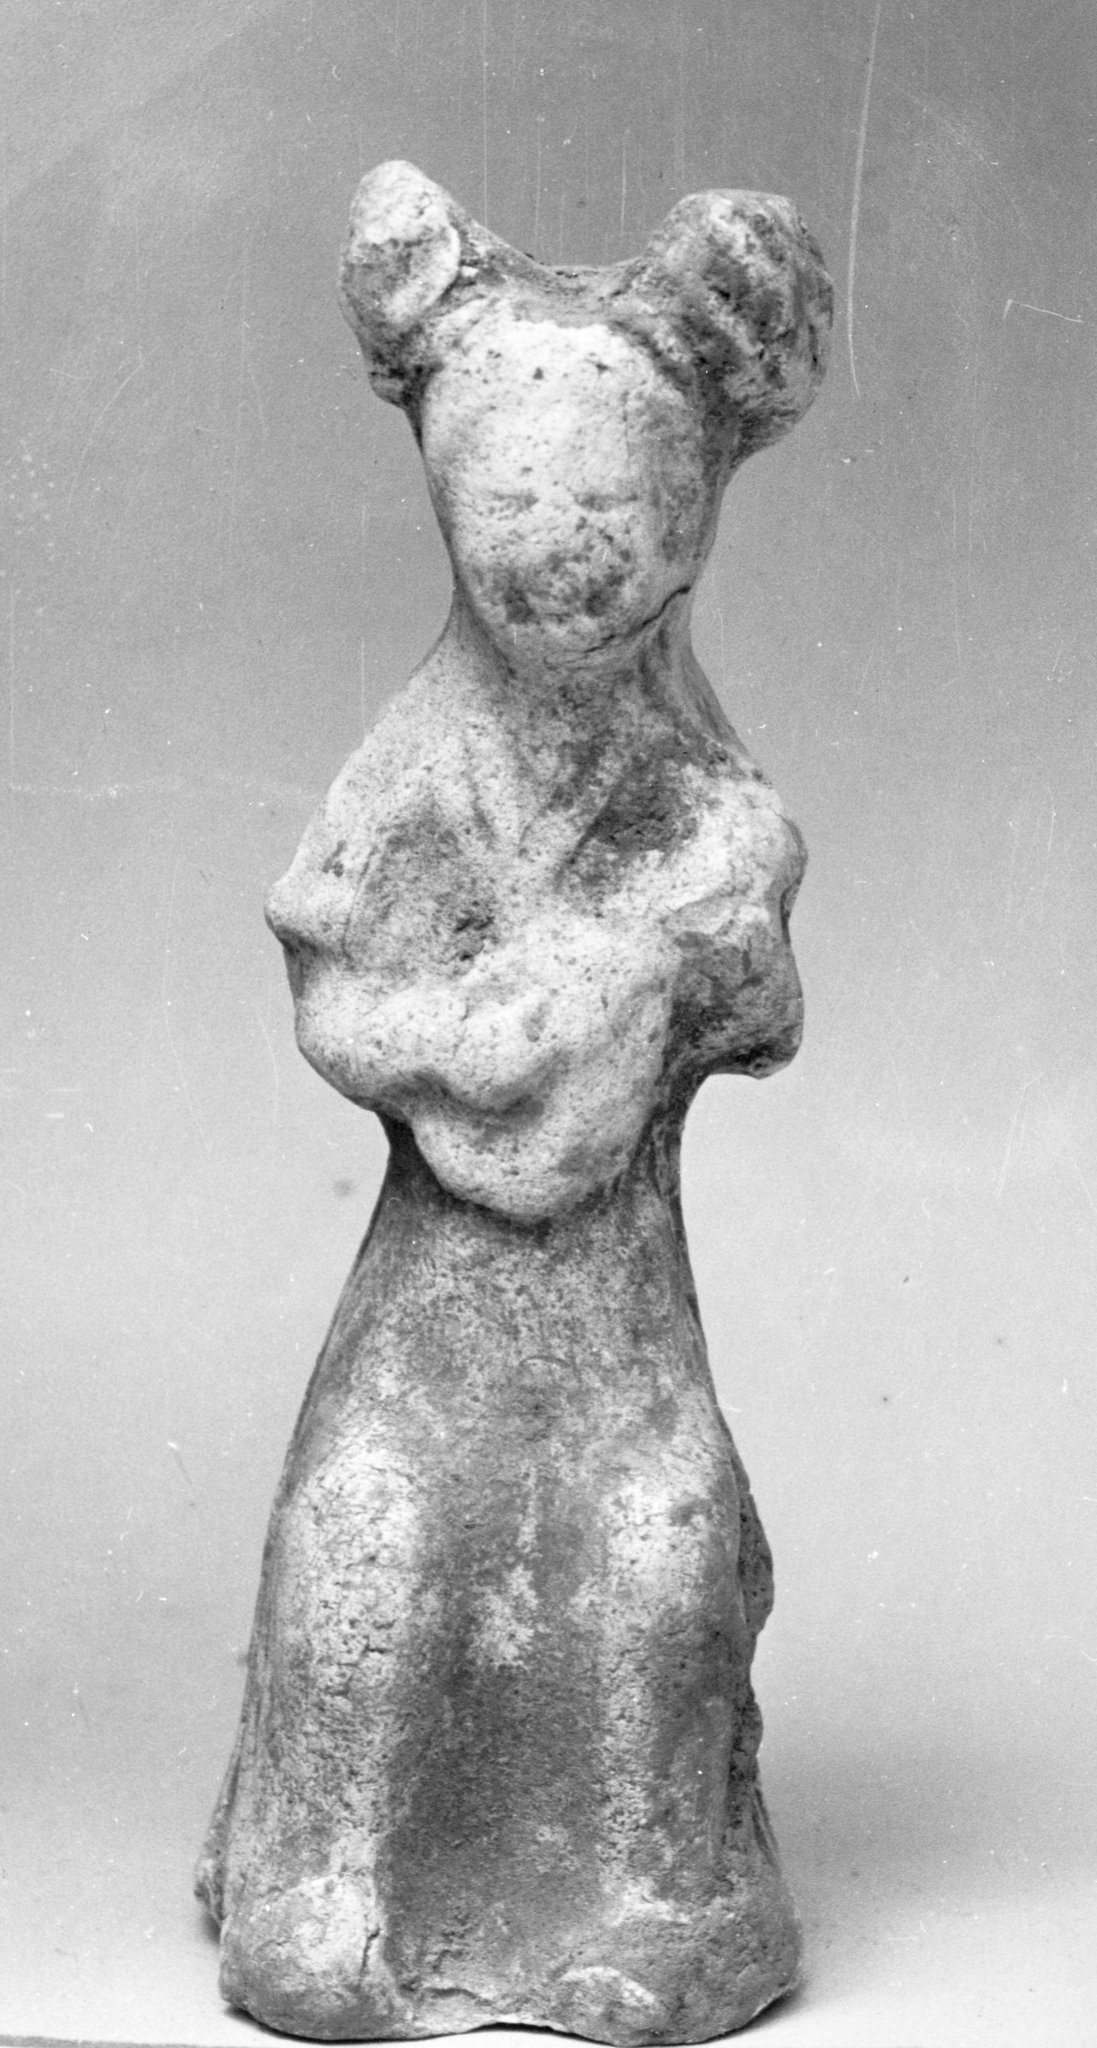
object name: figure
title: Seated female musician with lute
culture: chinese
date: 601-800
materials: earthenware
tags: human figures,musicians